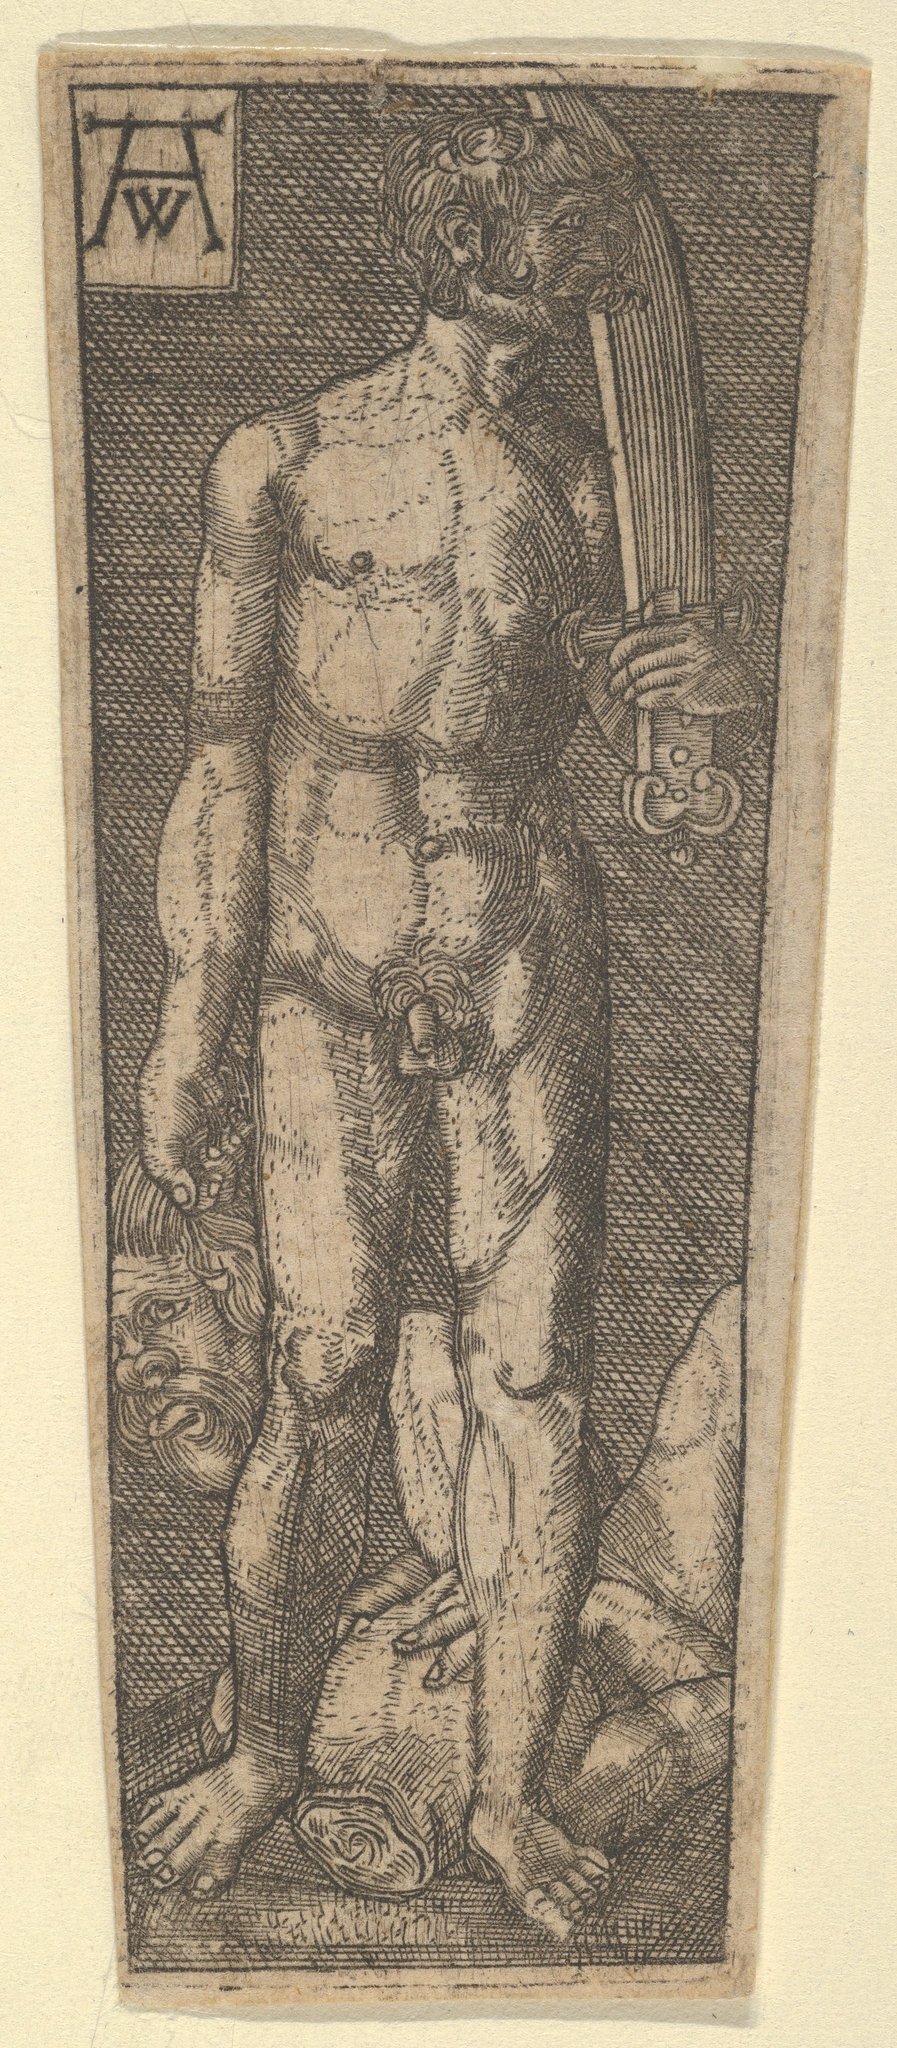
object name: print ornament architecture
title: Reverse Copy of the Top of Dagger Sheath with David Holding the Head of Goliath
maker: heinrich aldegrever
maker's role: artist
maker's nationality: german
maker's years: 1502-1561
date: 1529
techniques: engraving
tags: daggers,heads,david